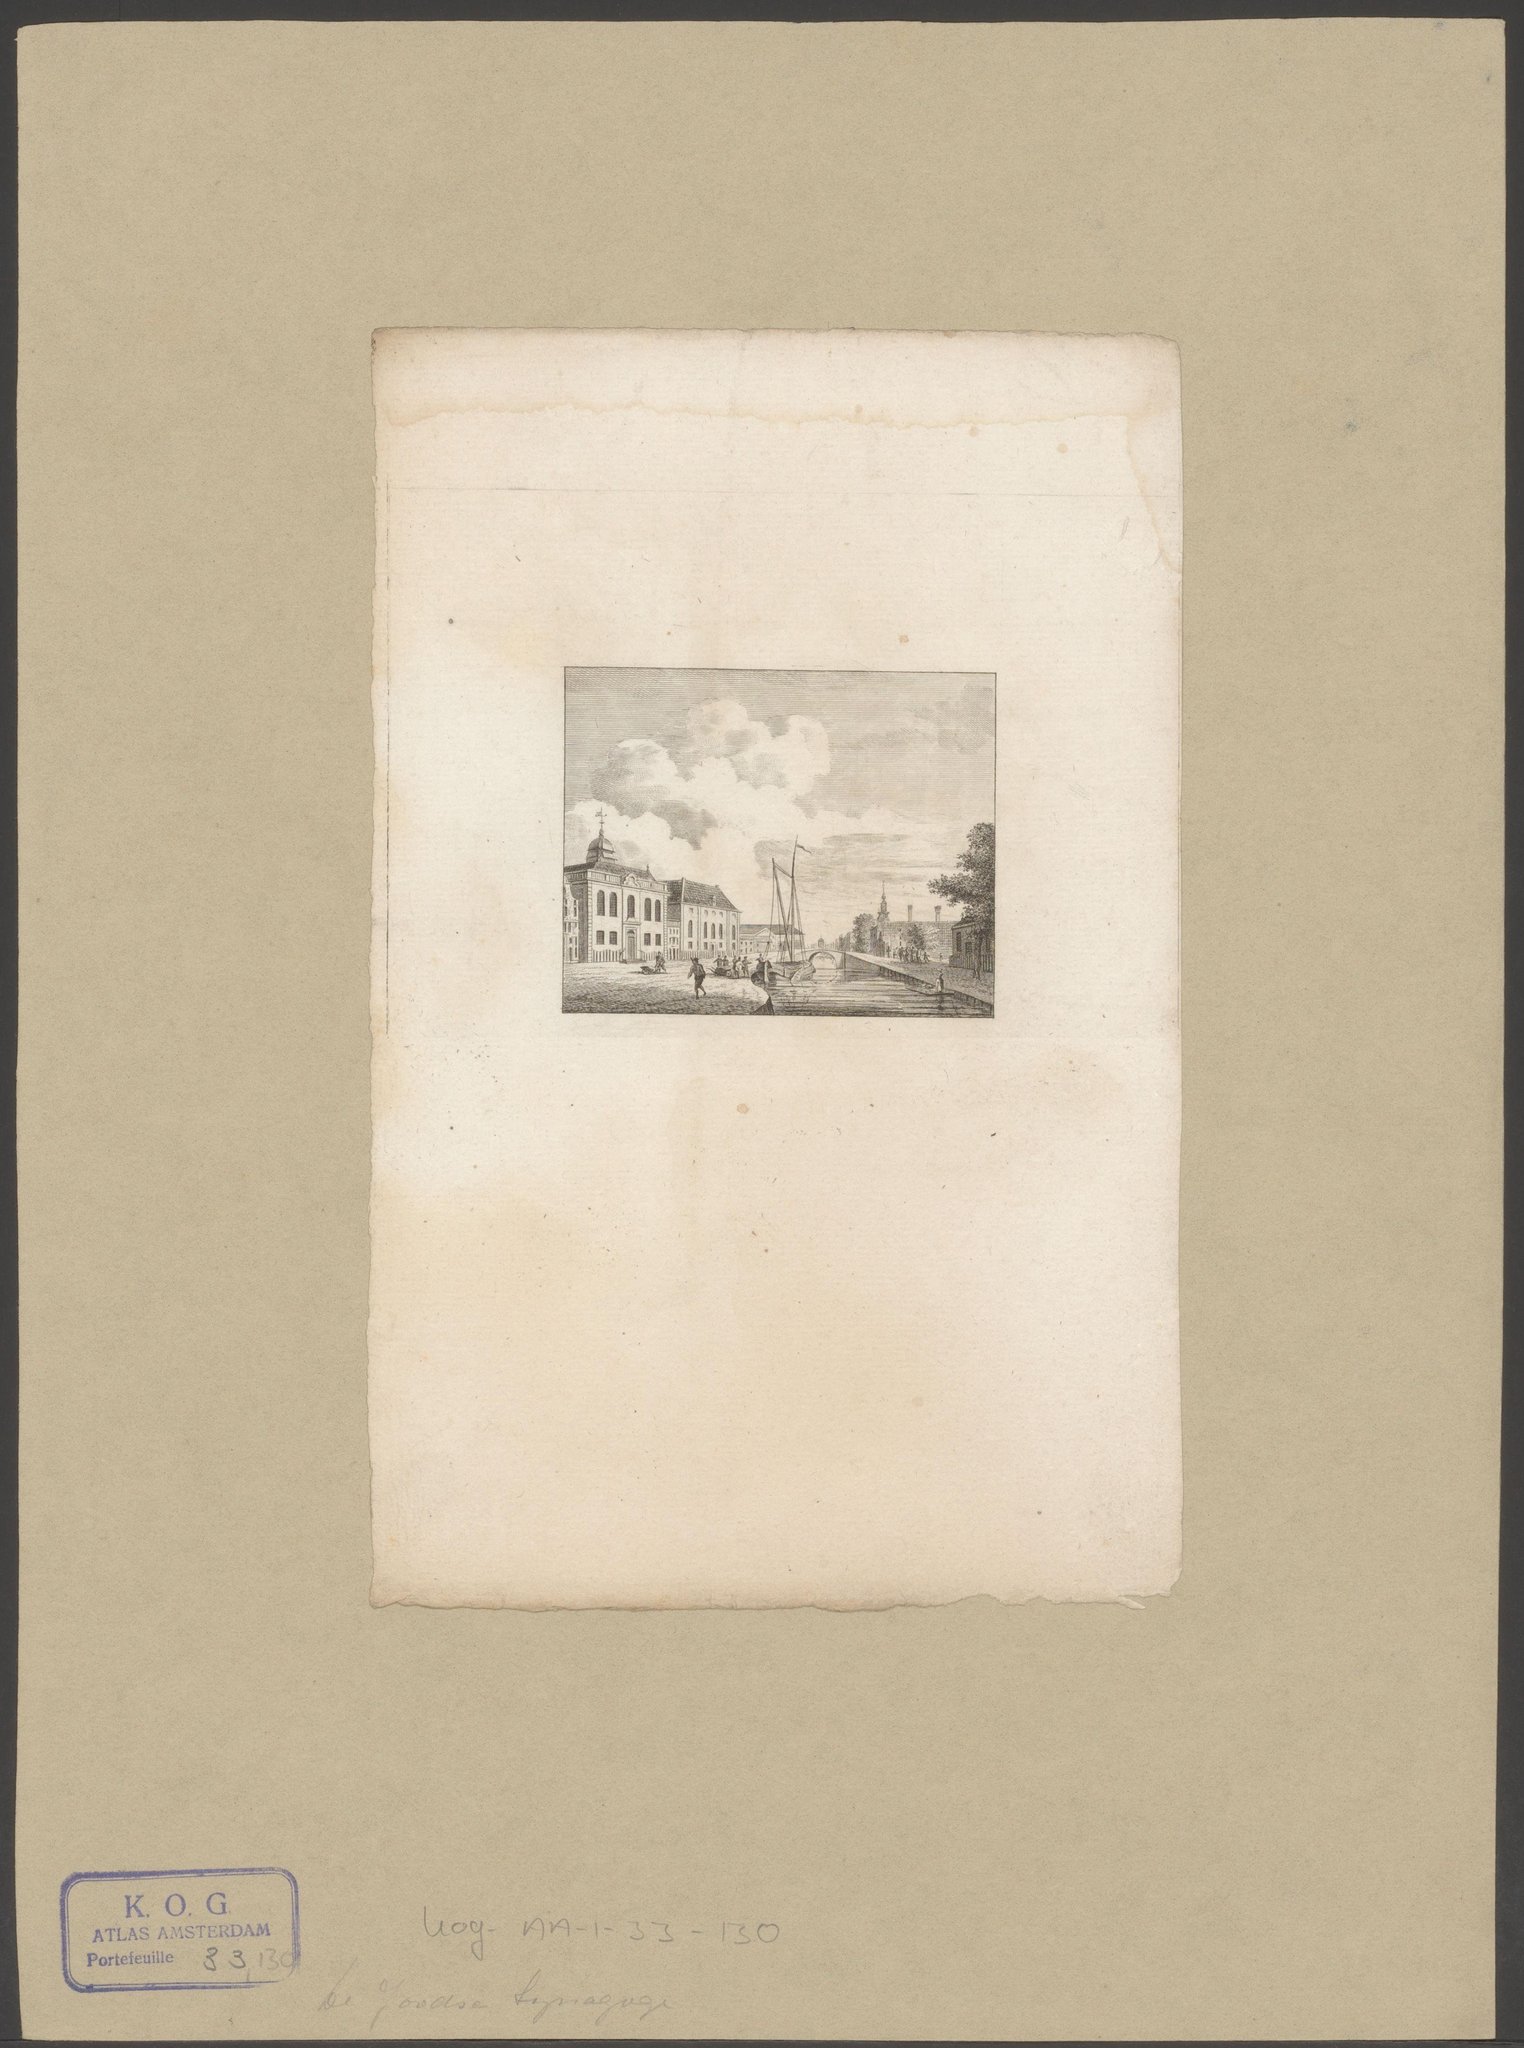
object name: print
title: Gezicht op de Nieuwe en Grote Synagoge te Amsterdam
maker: cornelis brouwer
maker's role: print maker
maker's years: 1731-1803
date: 1782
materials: paper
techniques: etching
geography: northern netherlands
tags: sailing-ship, sailing-boat, the synagogue (as building and place of worship ~ jewish religion), canals, waters (in city) (+ city(-scape) with figures, staffage)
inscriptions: collector's mark: Lugt 1641b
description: Latere staat van deze prent ook gebruikt in: Beschryving van Amsterdam verkort. Amsterdam: Hendrik Gartman en Izaak de Jongh, 1782. En in: Beschryving van Amsterdam verkort. Amsterdam: Johannes Wessing Willemsz. en Johannes van der Hey, 1788.